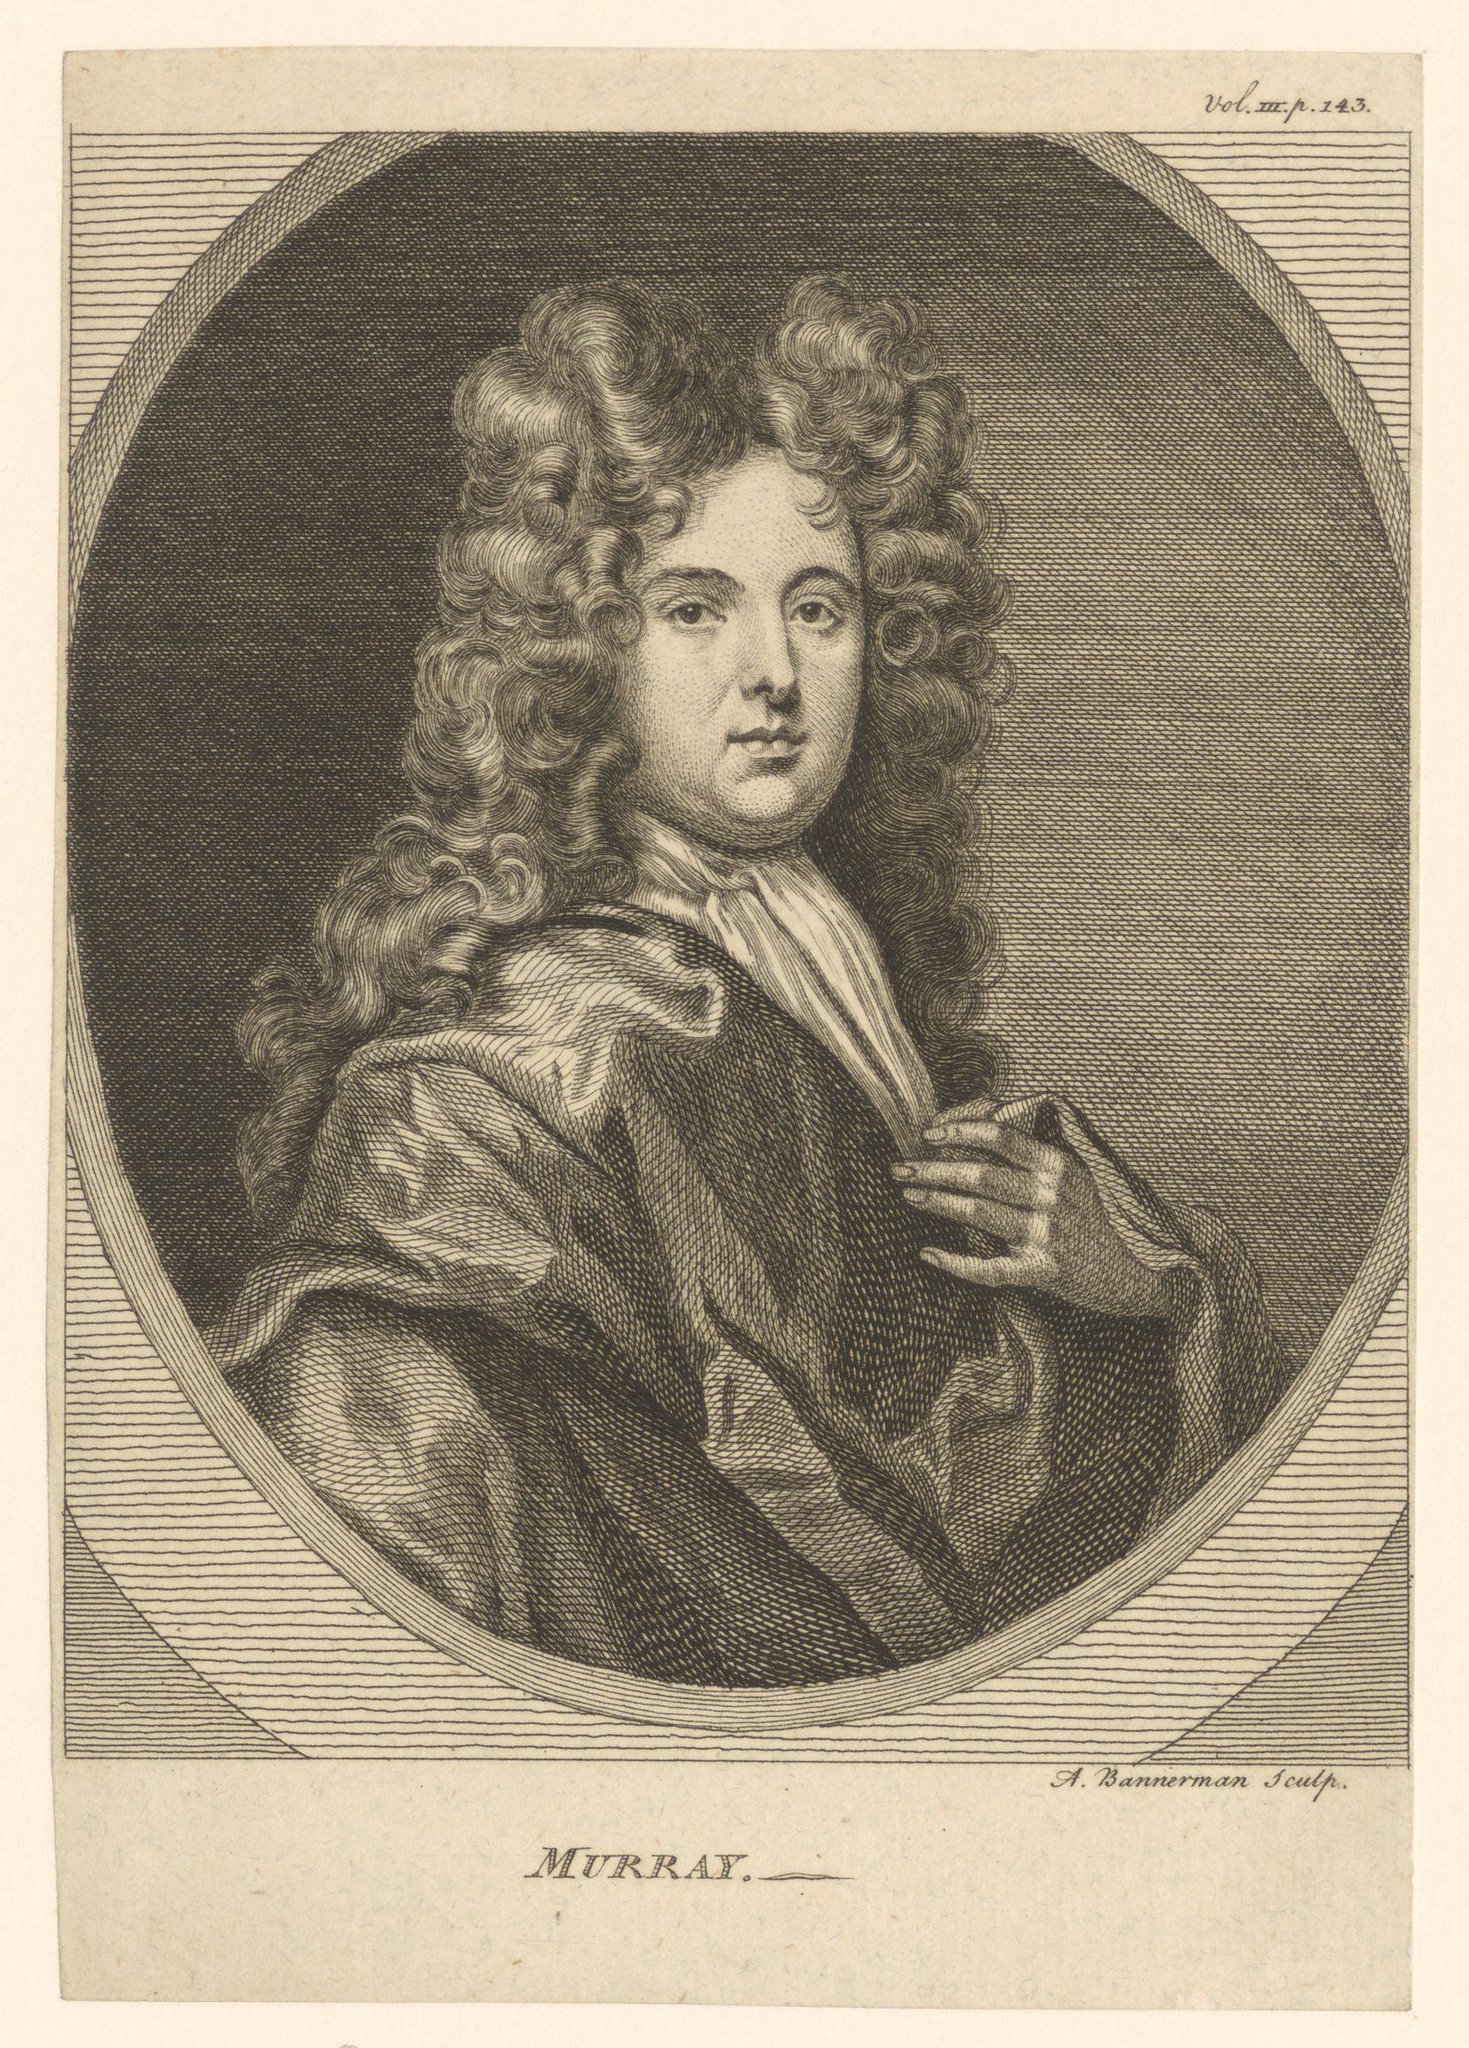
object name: print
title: Murray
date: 1763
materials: paper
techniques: engraving, etching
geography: england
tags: politician, david murray (2nd earl of mansfield), historical persons, politician, e.g. party leader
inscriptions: collector's mark: Lugt 2228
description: Prent uit: Vertue, George. Anecdotes of Painting in England (...). Londen: Horace Walpole, 1763, dl. 3, p. 143.